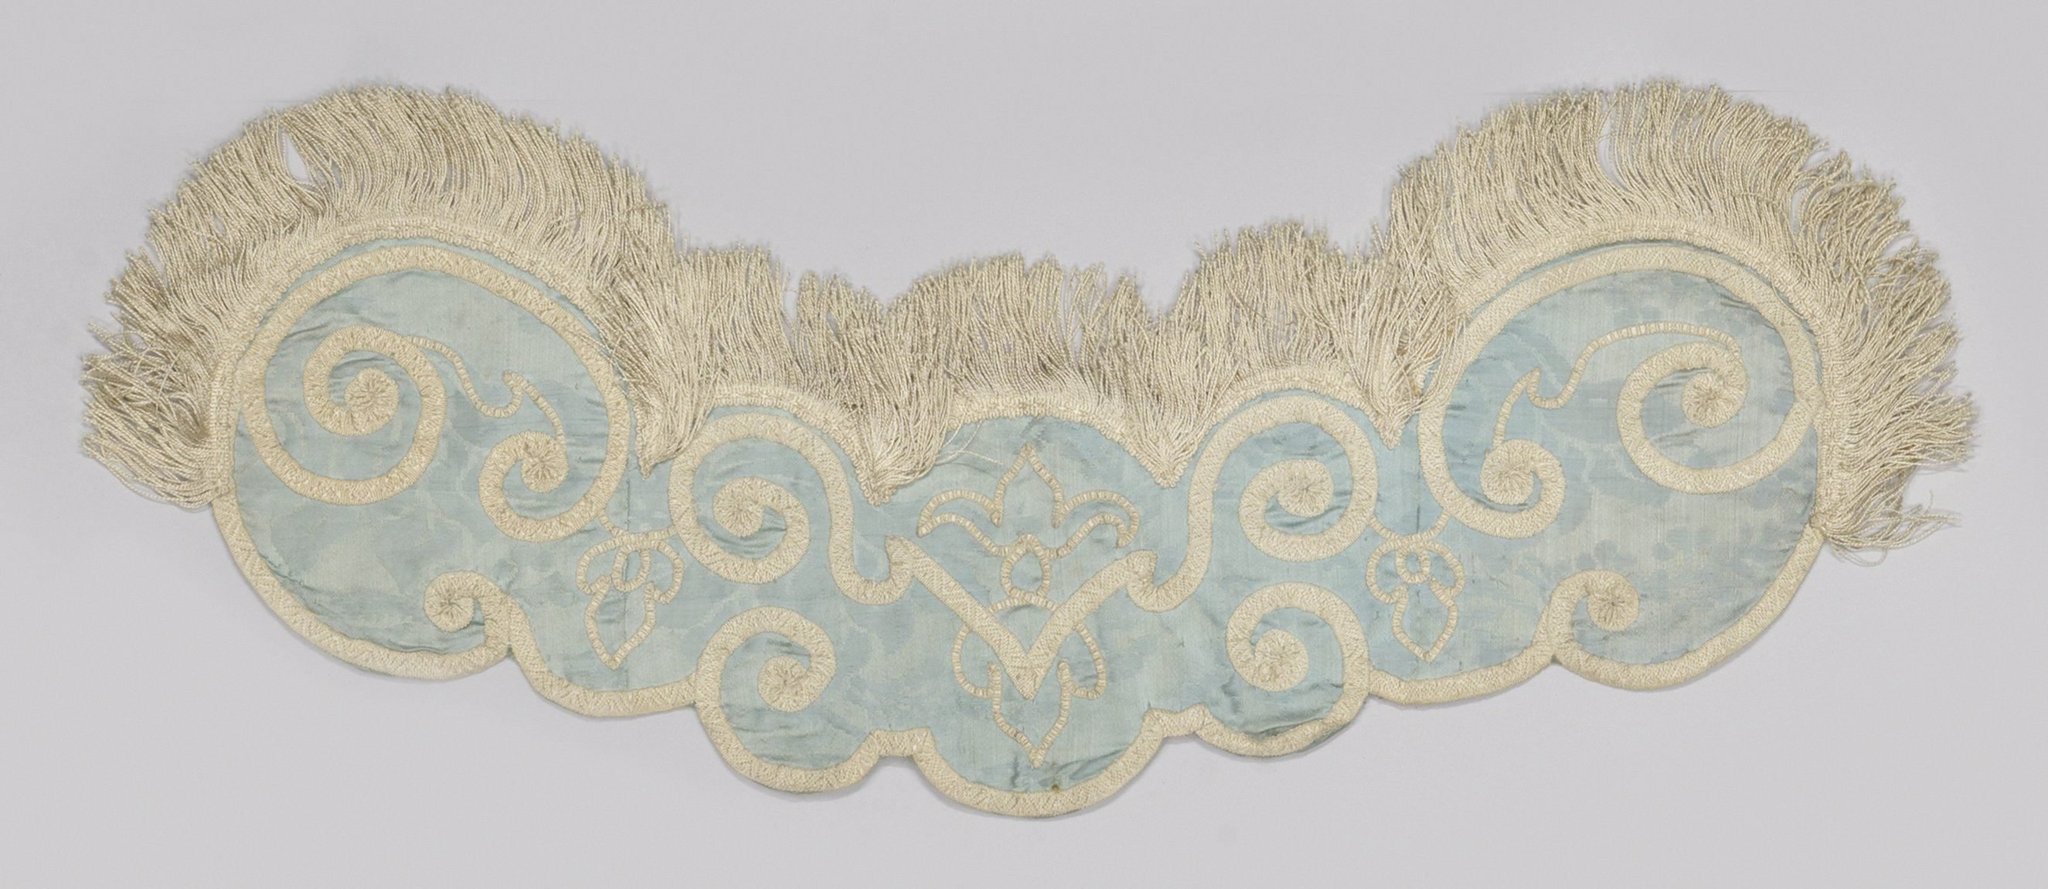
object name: lambrequin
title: Lambrekijn van een wieg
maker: Anonymous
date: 1700-1750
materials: silk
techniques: damask, embroidered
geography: china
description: Lambrekijn voor een wieg, van lichtblauw zijdedamast met een patroon van enigszins grillig gevormde, geborduurde bloemen, aan de onderrand bestikt met crèmekleurig beweven band in een patroon van voluten, afgezet met crèmekleurige franje.